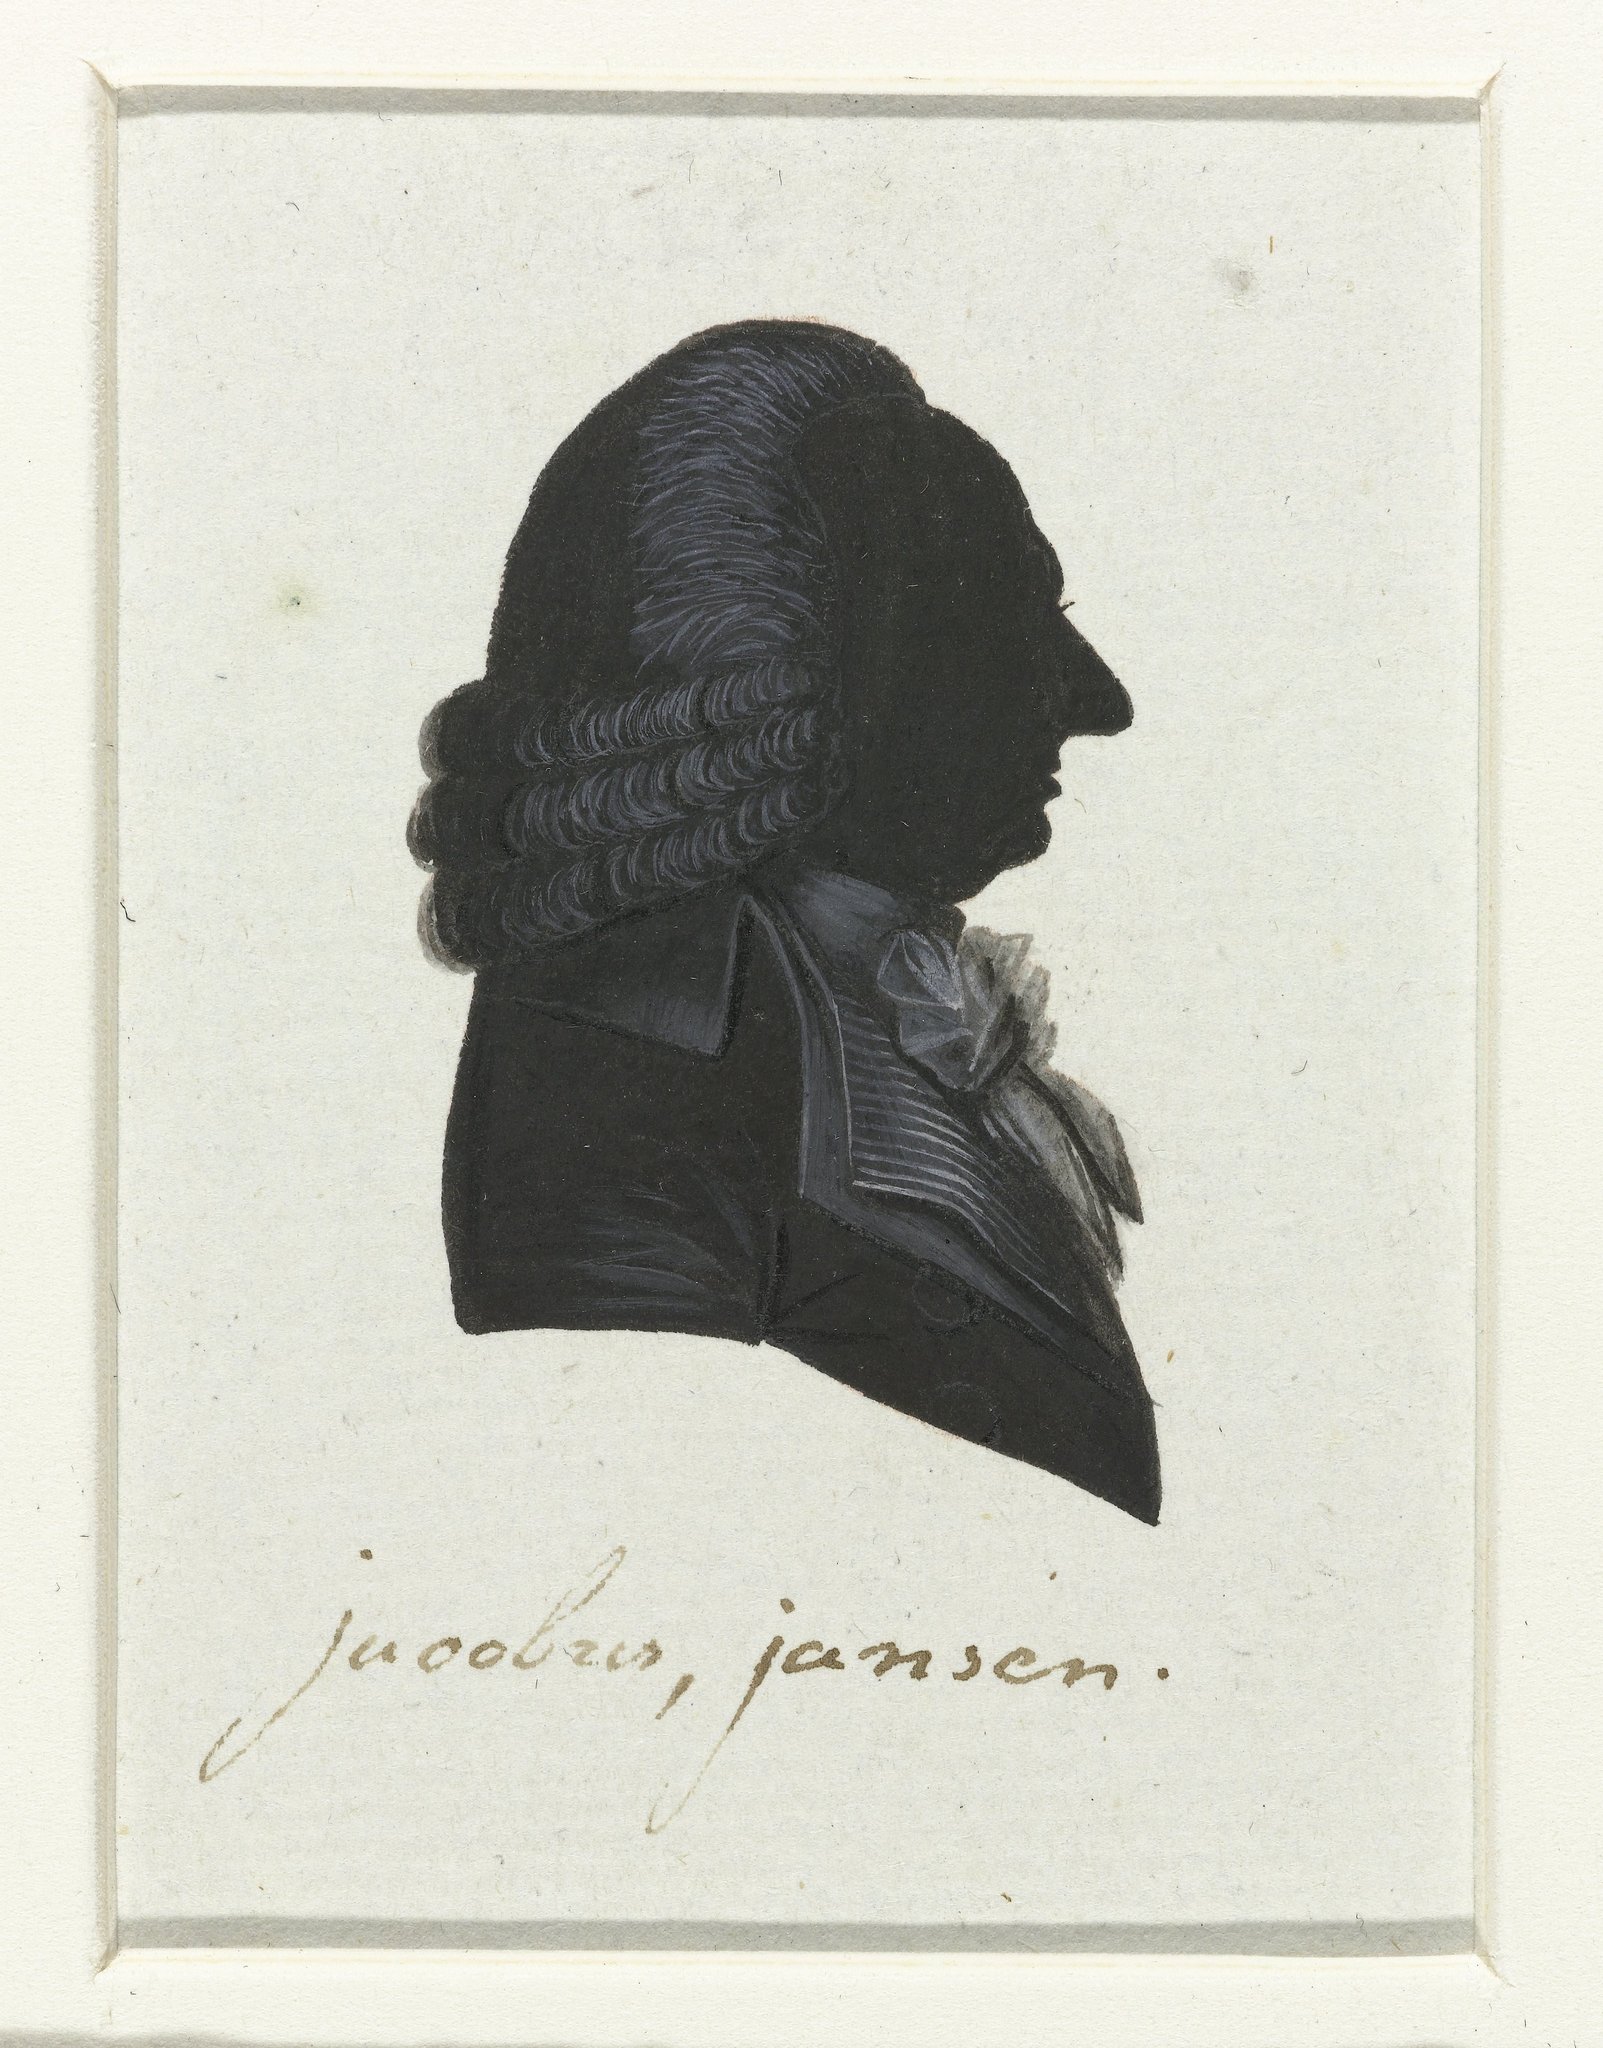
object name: silhouette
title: Representanten van de eerste Nationale Vergadering van de Bataafse Republiek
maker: hausdorff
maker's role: draughtsman, print maker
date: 1796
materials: ink, paper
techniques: drawing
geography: netherlands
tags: historical persons (+ profile portrait), the hague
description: Silhouettes of members of the National Assembly. India ink on paper, 1796. Early in 1795 Stadholder William V fled to England. In the Republic a new regime was installed. A year later, the country held its first general election. Every Dutch man over the age of twenty and not on poor relief was entitled to vote for a candidate to the National Assembly, the parliament of the Batavian Republic, as the country was known between 1795 and 1806. The 126 representatives who sat in the assembly were drawn from the educated, progressive elite of Dutch society.